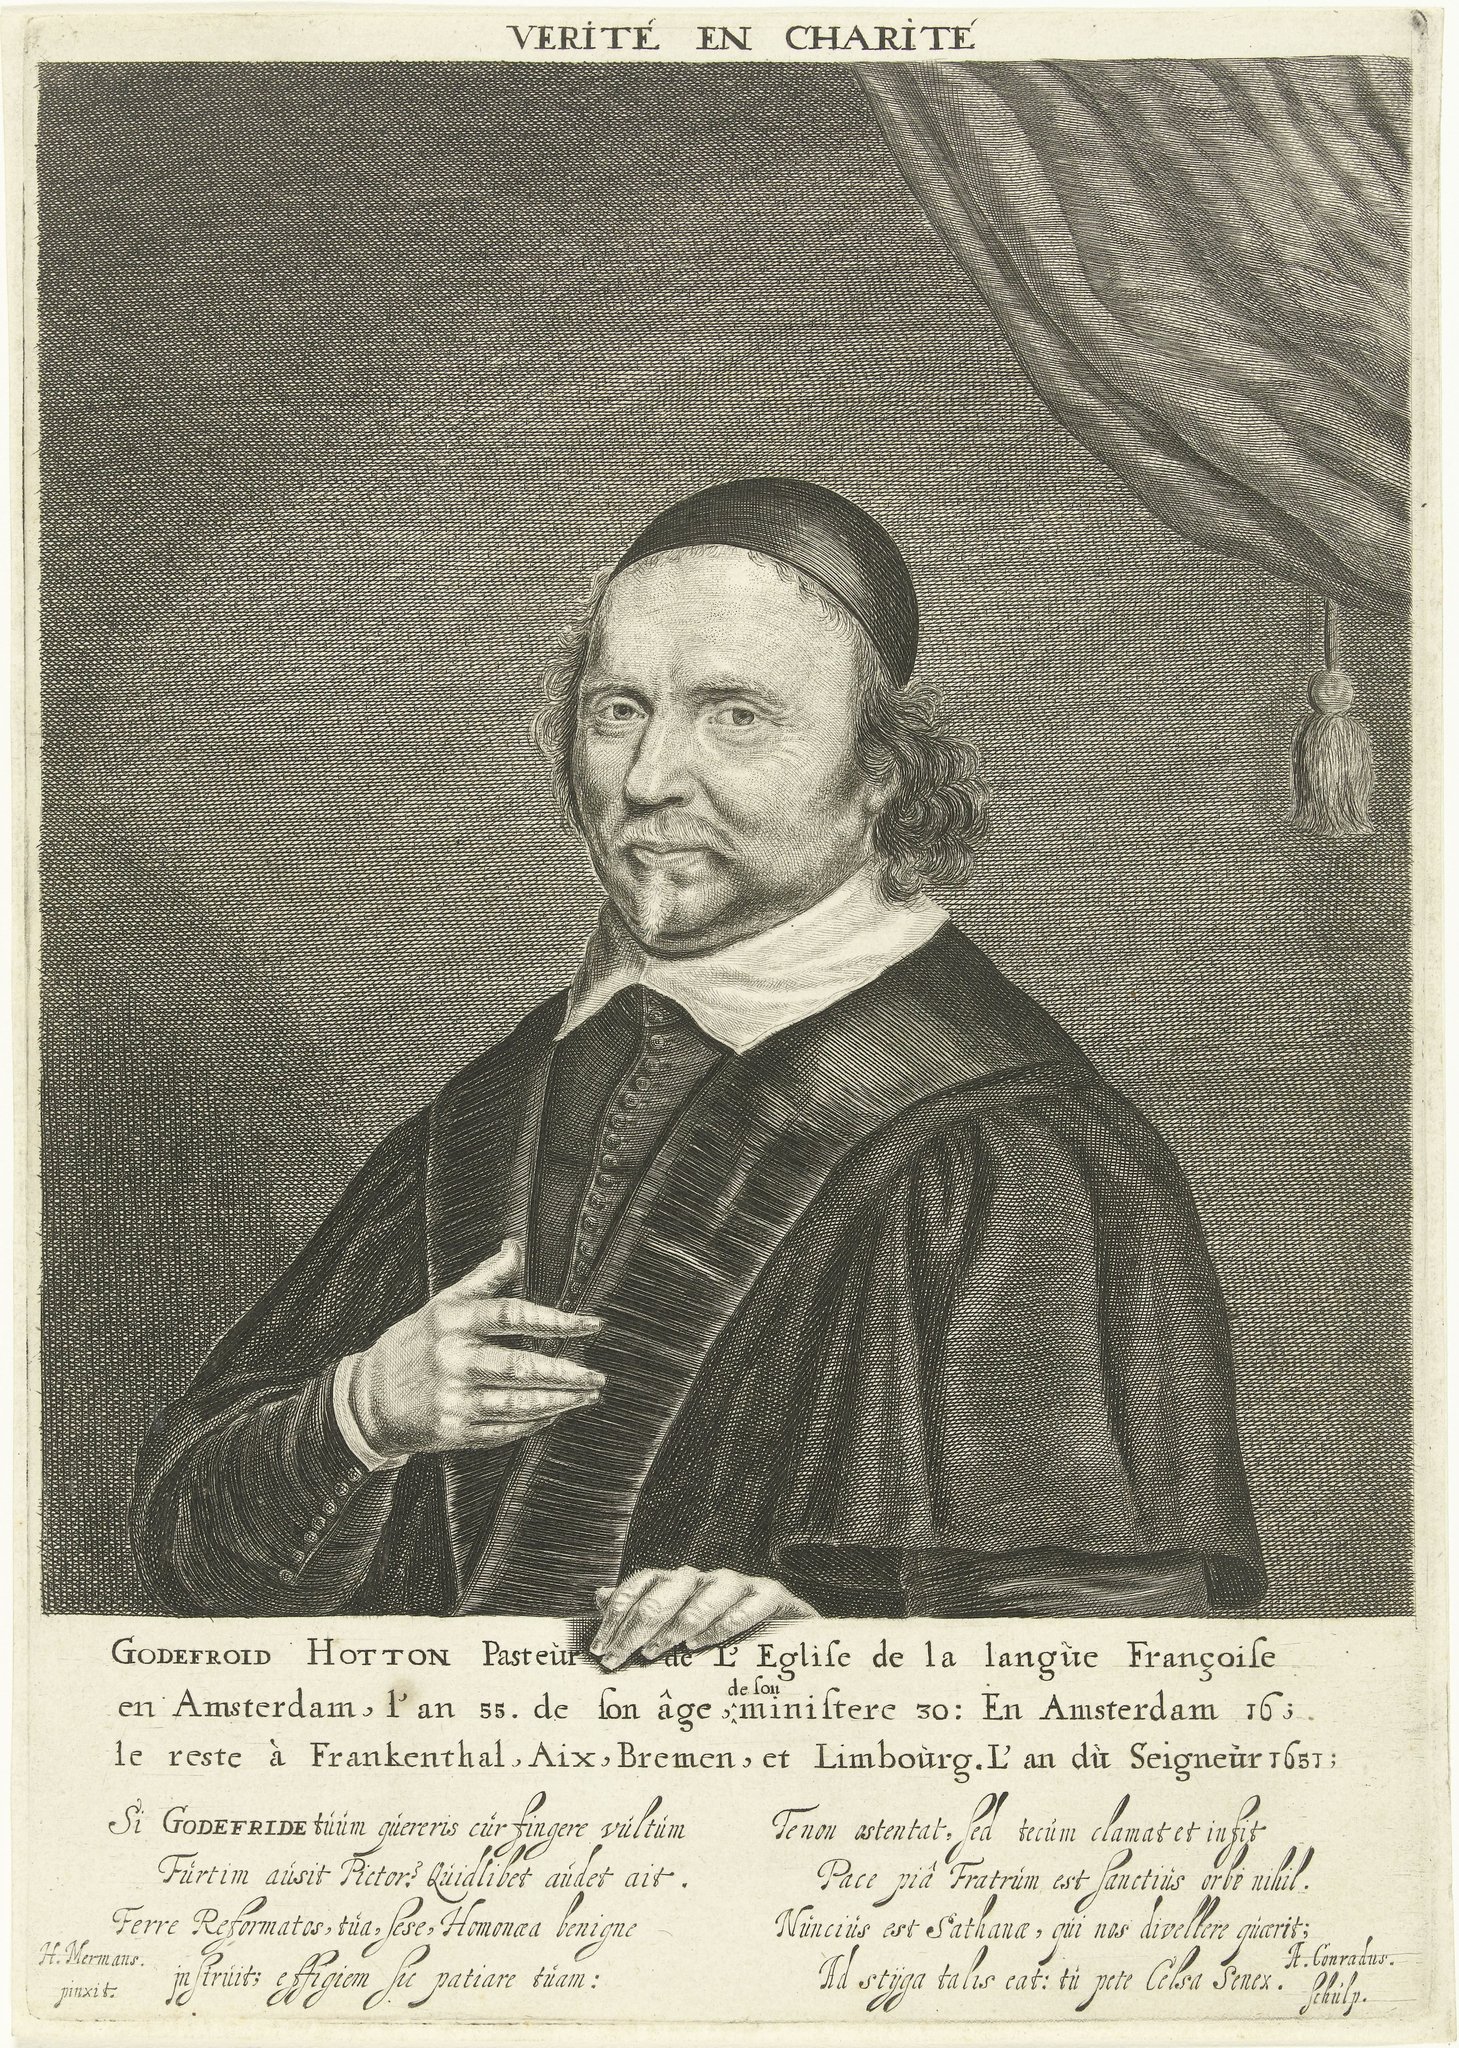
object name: print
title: Portret van Godefroid Hotton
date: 1651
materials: paper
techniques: engraving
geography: amsterdam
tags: predikant, godefroid hotton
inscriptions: collector's mark: Lugt 2228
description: Borstbeeld van Godefroid Hotton, predikant in de Waalse kerk te Amsterdam. Boven het portret zijn motto: Verité en charité. Onder het portret een Franse tekst over Hotton en een Latijns vers op hem.